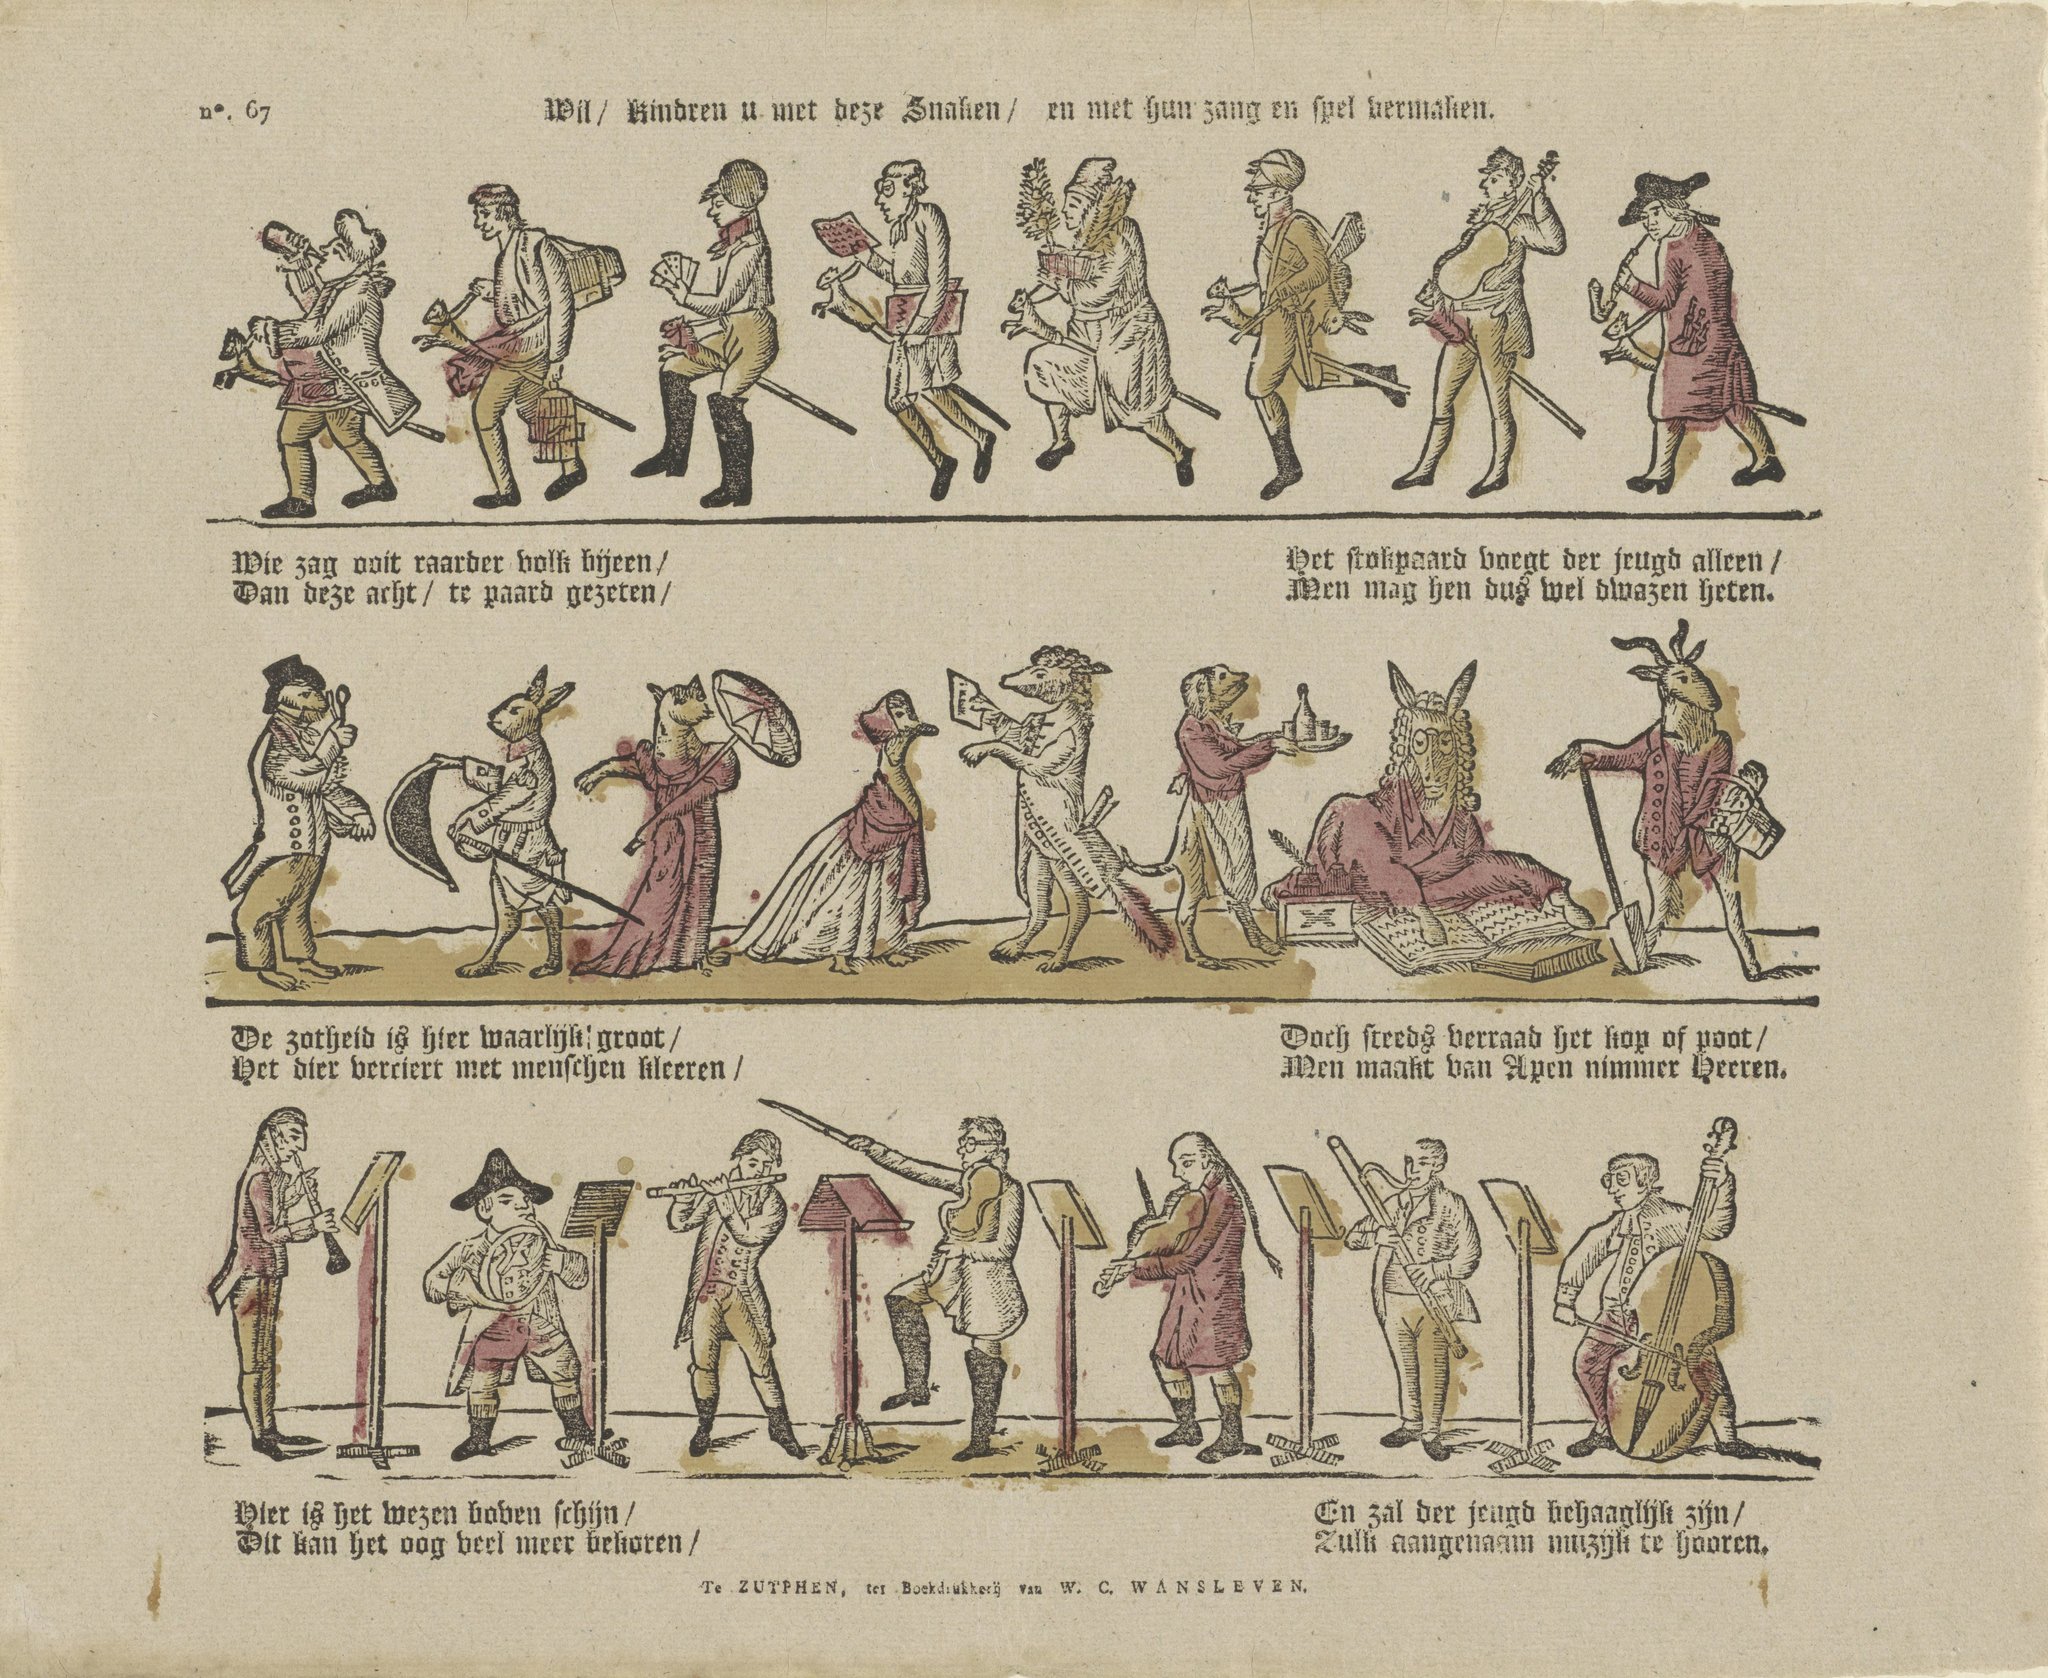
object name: print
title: Wil / kinderen u met deze snaken / en met hun zang en spel vermaken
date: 1806-1858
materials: paper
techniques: colour, letterpress printing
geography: netherlands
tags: musician at work, musician, hobby-horse, animals acting as human beings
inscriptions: collector's mark: Lugt 2760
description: Blad met 3 horizontale rijen met voorstellingen van volwassen mannen op stokpaardjes, verklede dieren en muzikanten. Onder elke voorstelling een vierregelig vers in twee kolommen. Genummerd linksboven: no. 67.